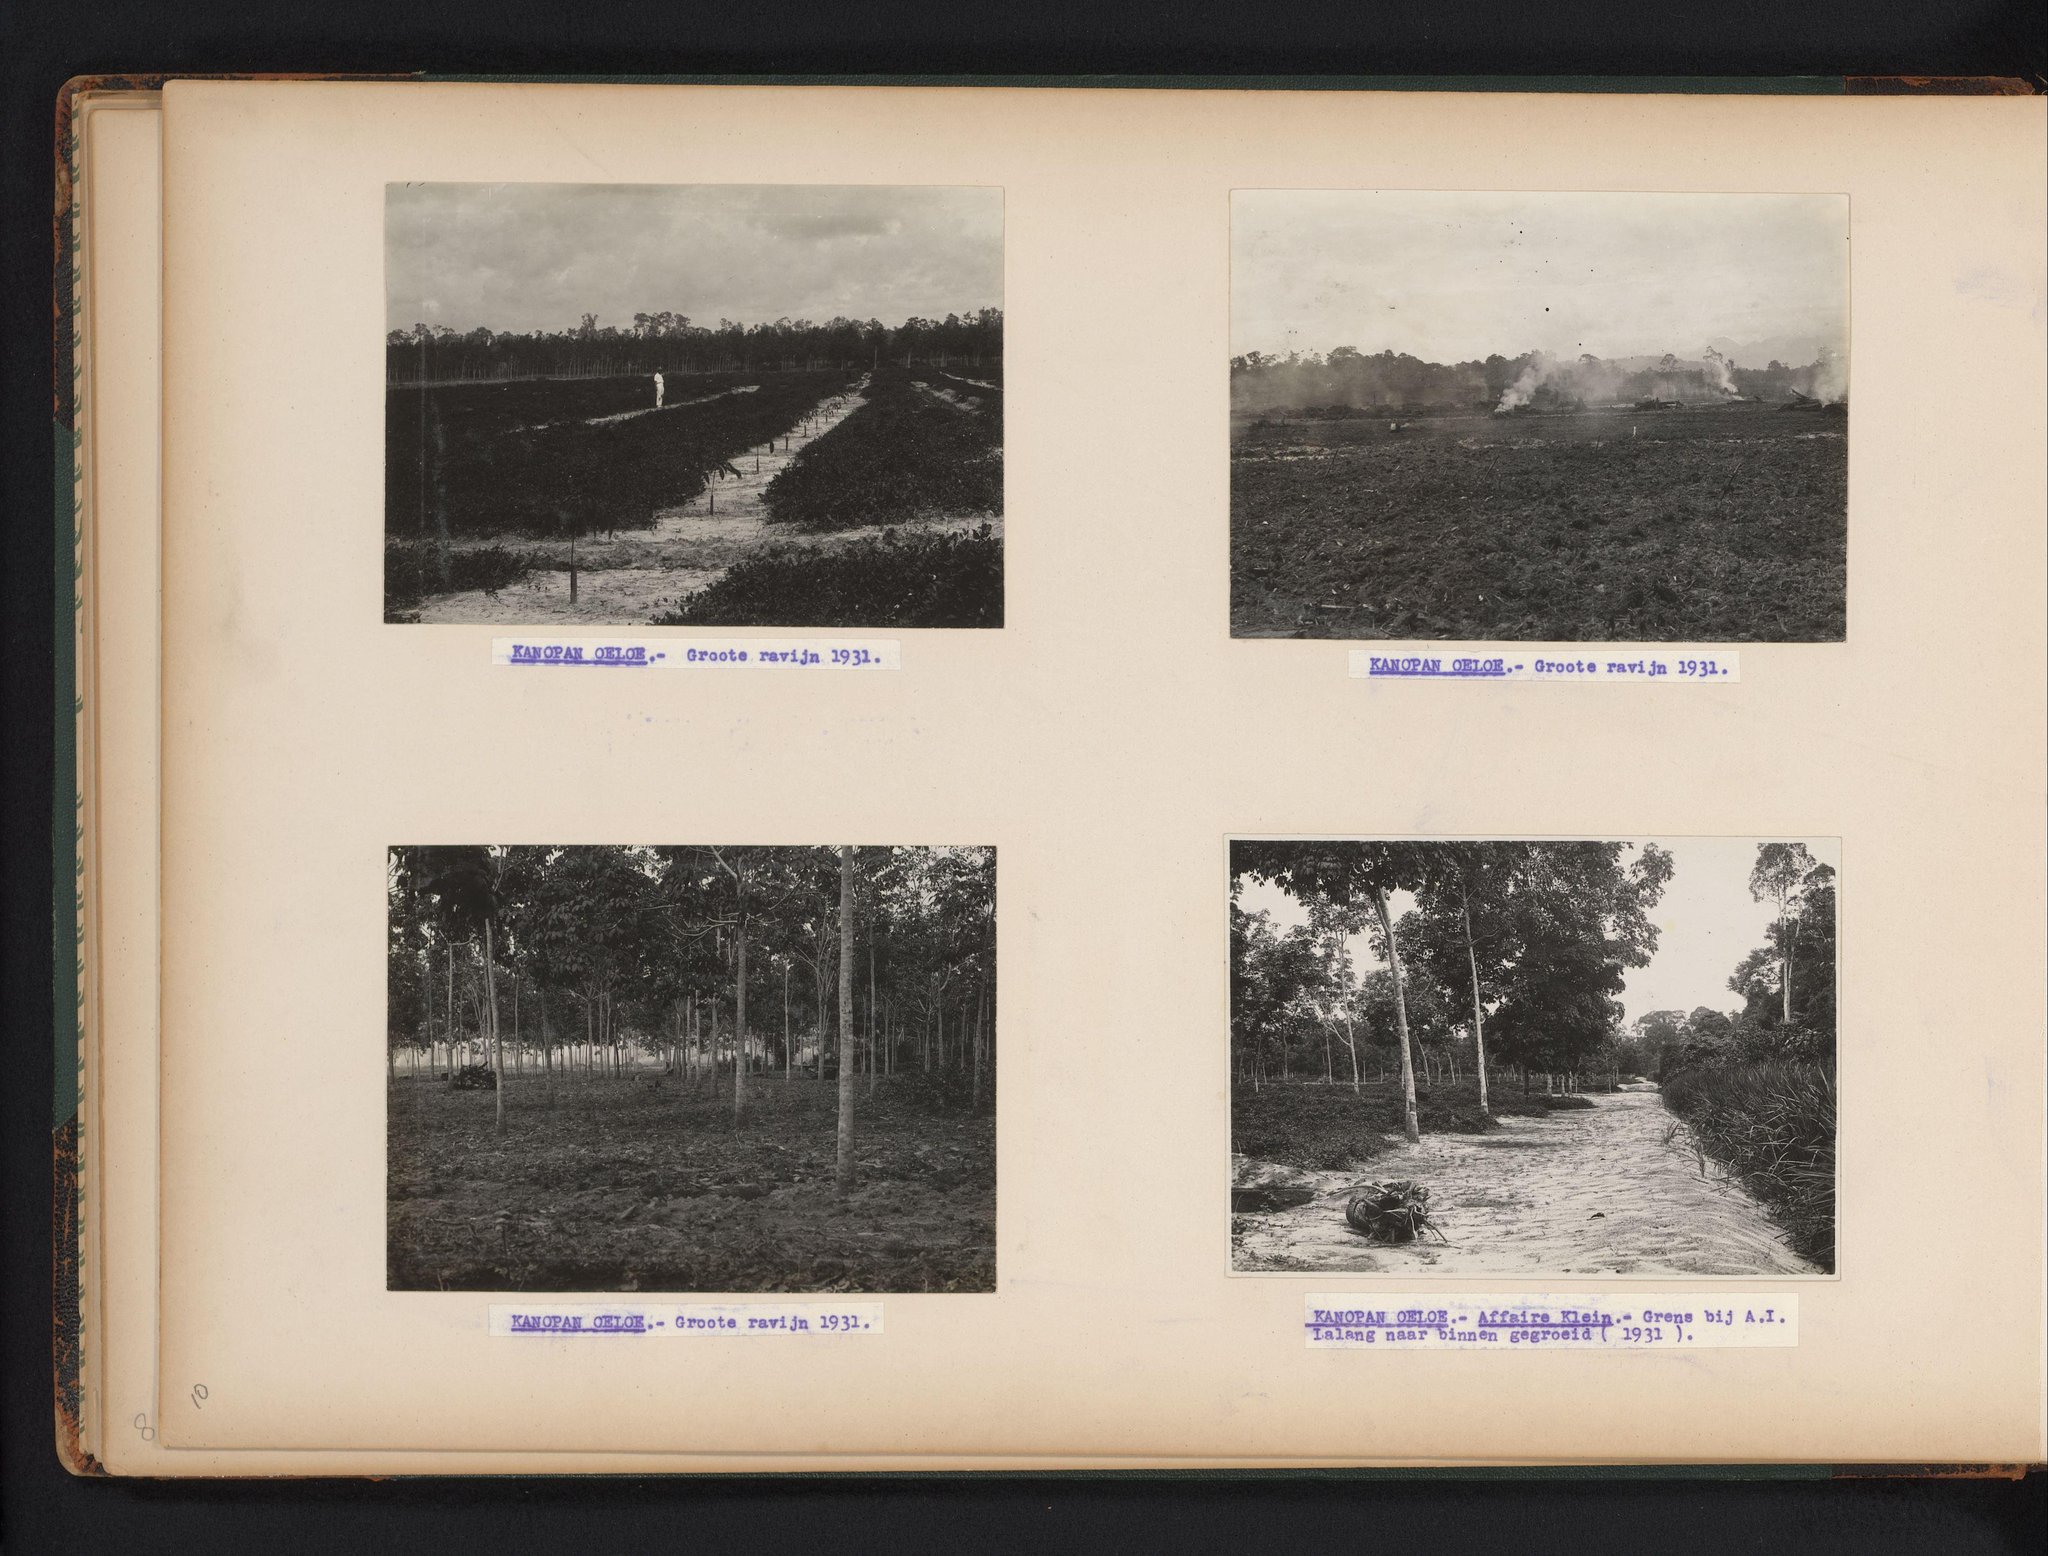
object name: album leaf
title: Rubberbomen op Kanopan Oeloe, 1931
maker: Anonymous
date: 1931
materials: cardboard, photographic support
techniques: gelatin silver print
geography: sumatra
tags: plantation, (non-fruit) products of plants or trees: rubber, sumatra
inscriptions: inscription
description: Blad met vier foto's van beplanting met rubberbomen op Kanopan Oeloe, 1931. Onderdeel van het fotoalbum over de plantages Leidong West en Kanopan Oeloe van de Cultuur Maatschappij Leidong West op Sumatra in de jaren 1925-1939.